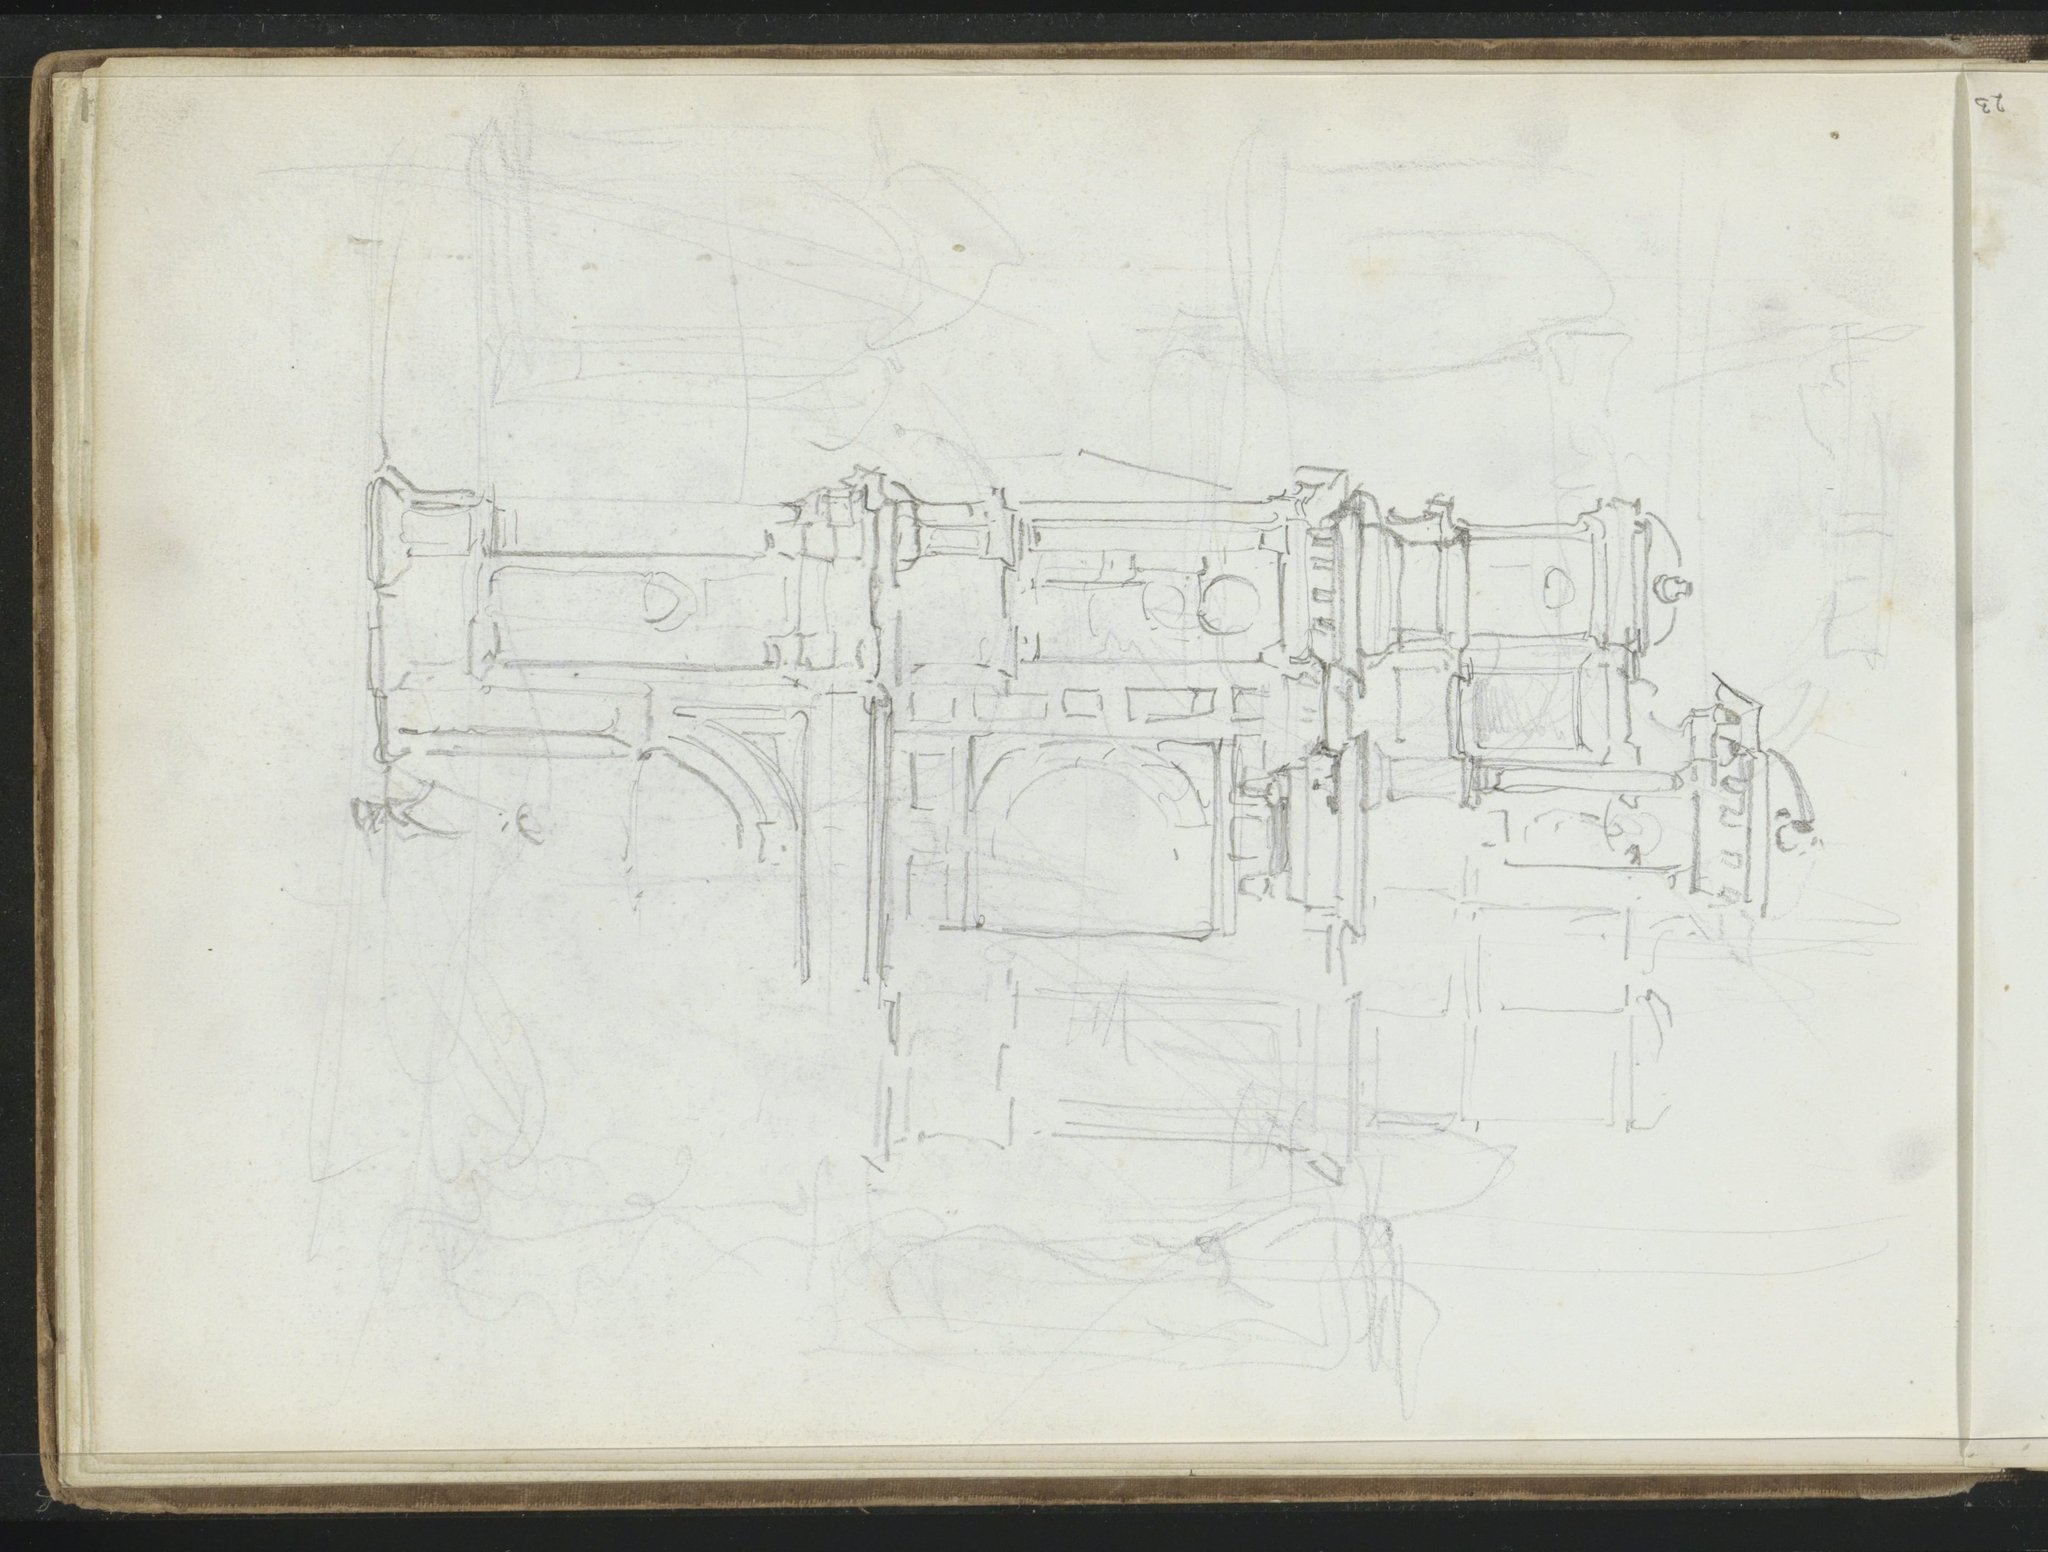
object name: sketchbook leaf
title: Vooraanzicht van een bouwwerk met drie verdiepingen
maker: johannes bosboom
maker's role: draughtsman, painter, print maker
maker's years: 1817-1891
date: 1827-1891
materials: paper, pencil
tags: architecture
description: Mogelijk een deel van een kerkinterieur. Blad 11 verso uit een schetsboek met 41 pagina's.